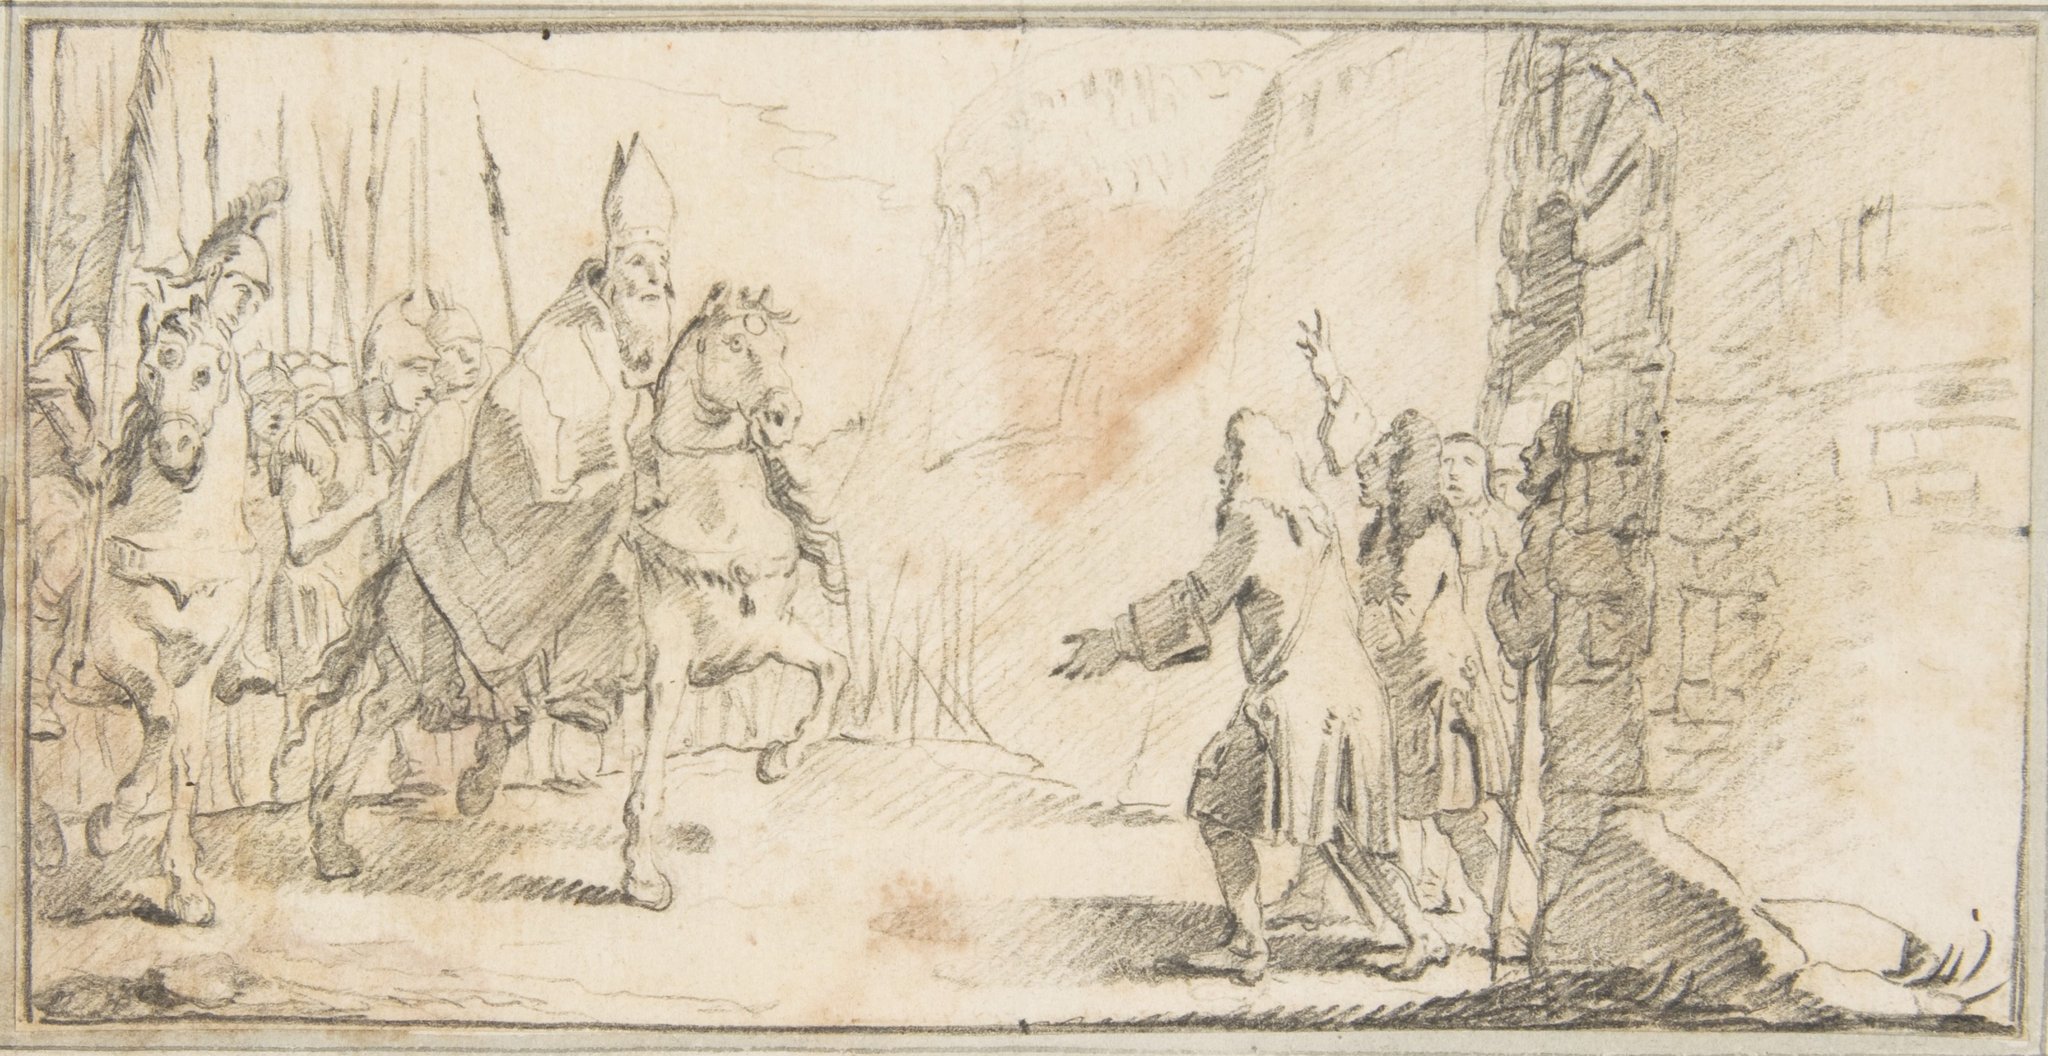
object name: drawing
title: Illustration for a Book: Reception of a Bishop Leading an Army at a City Gate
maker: giovanni battista tiepolo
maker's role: artist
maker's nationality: italian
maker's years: 1696-1770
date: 1696-1770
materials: chalk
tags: gates,army,horses,bishops